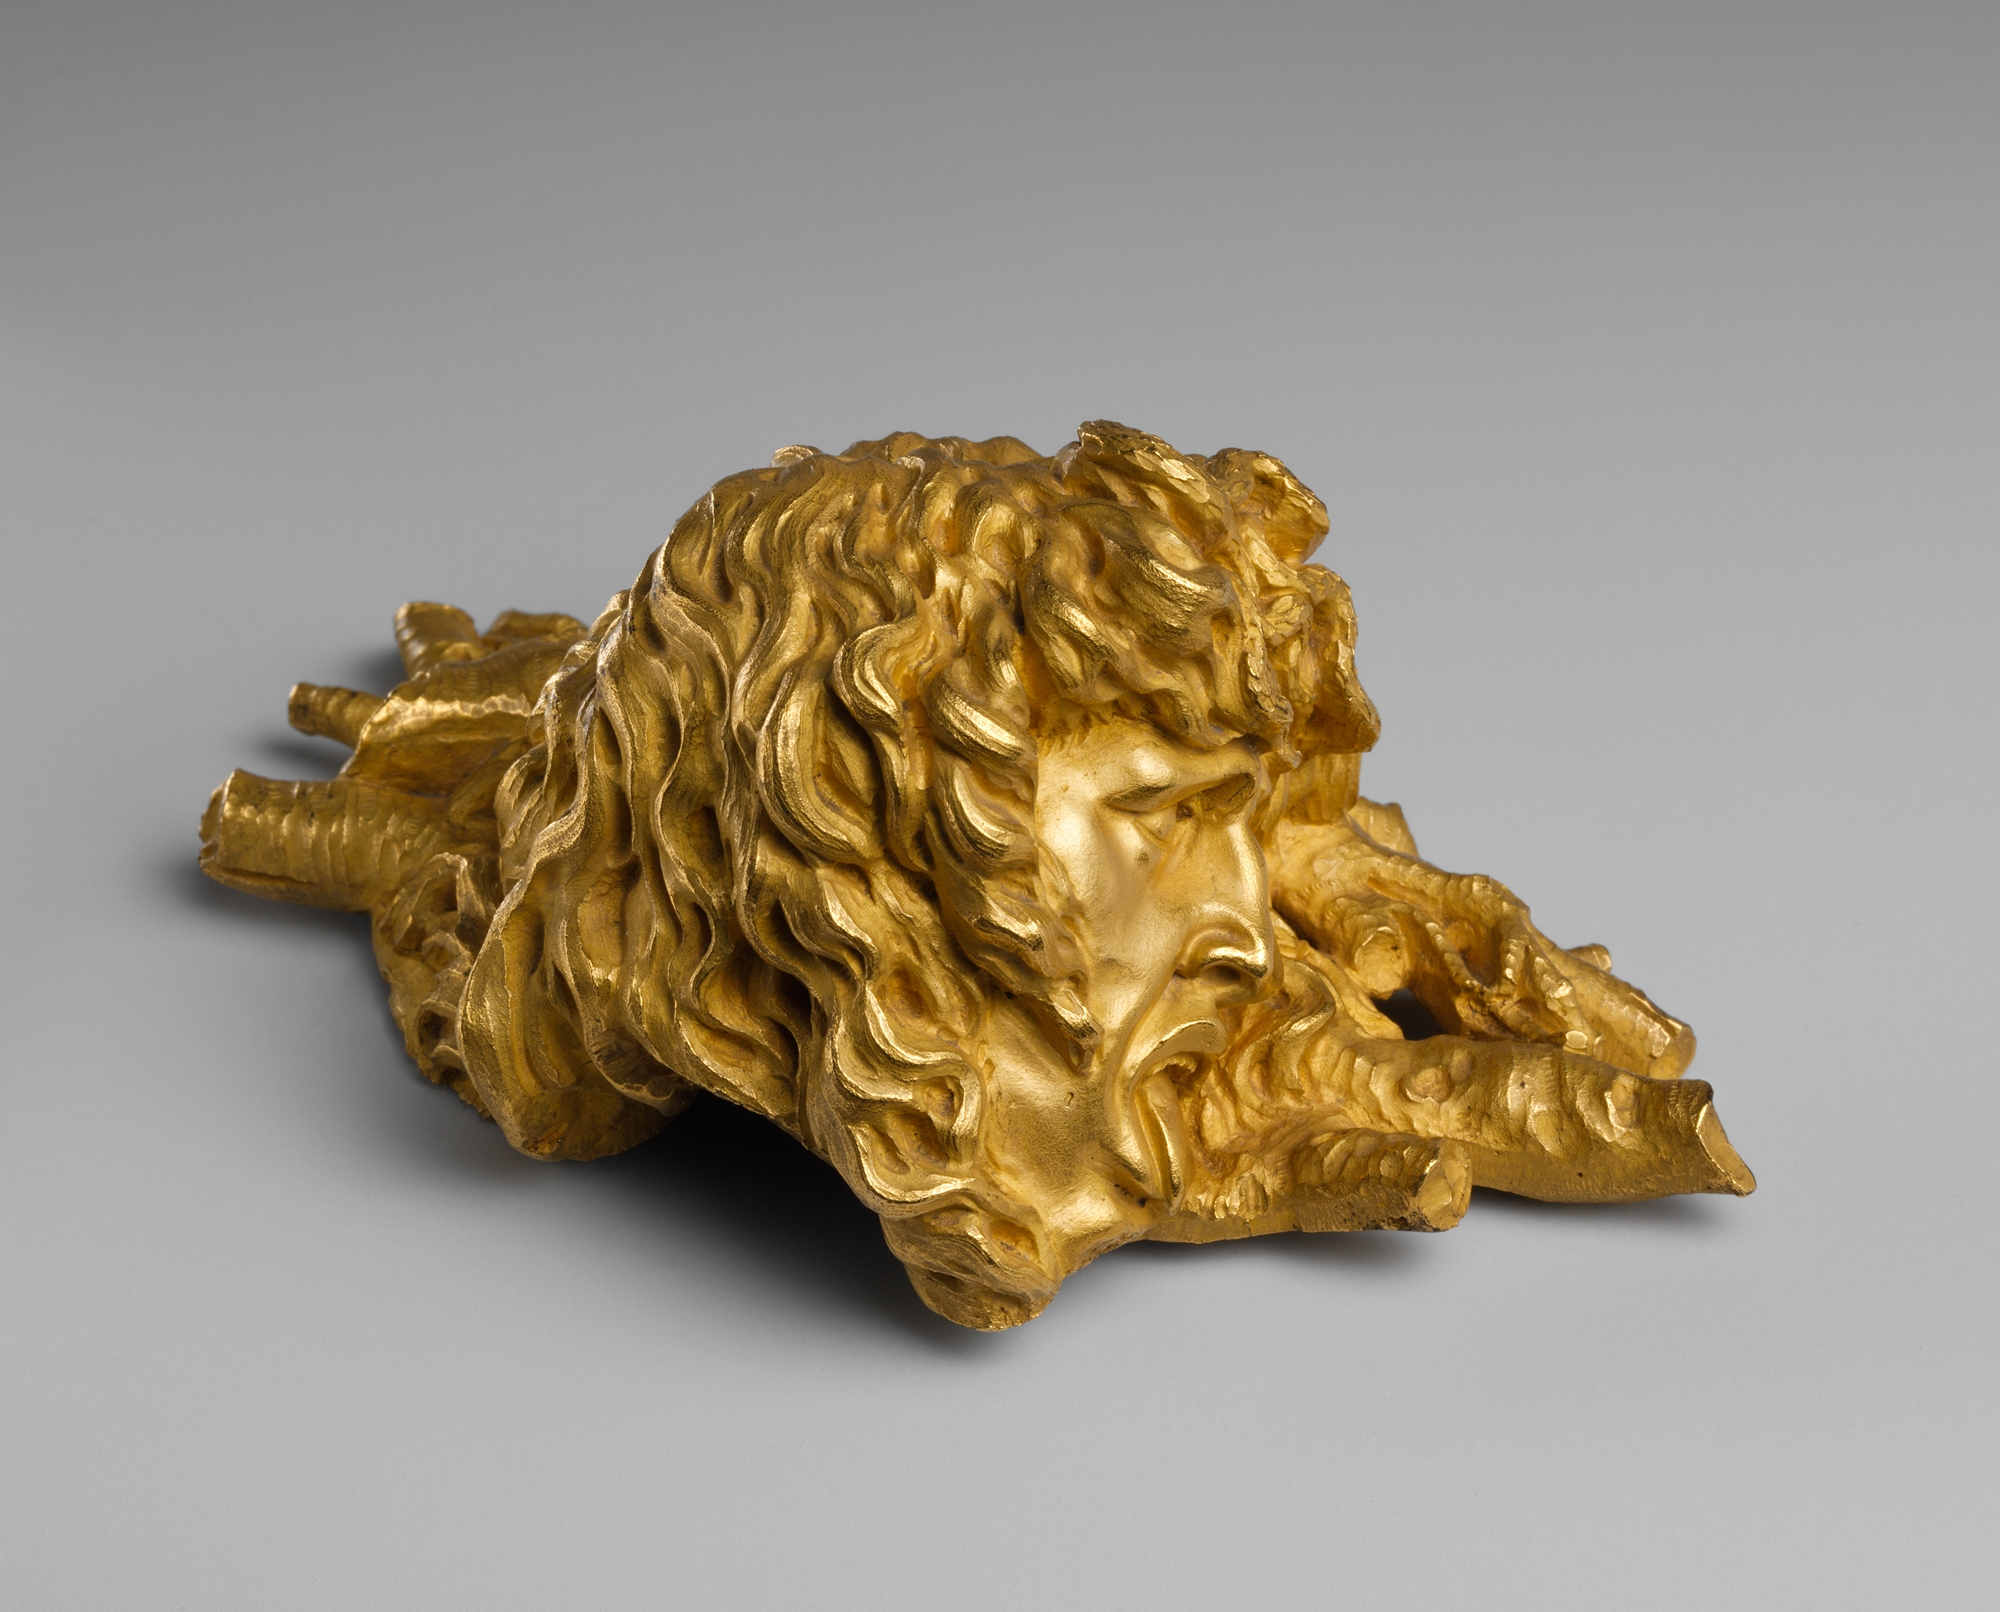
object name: clock ornament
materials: gilt bronze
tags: heads,medusa